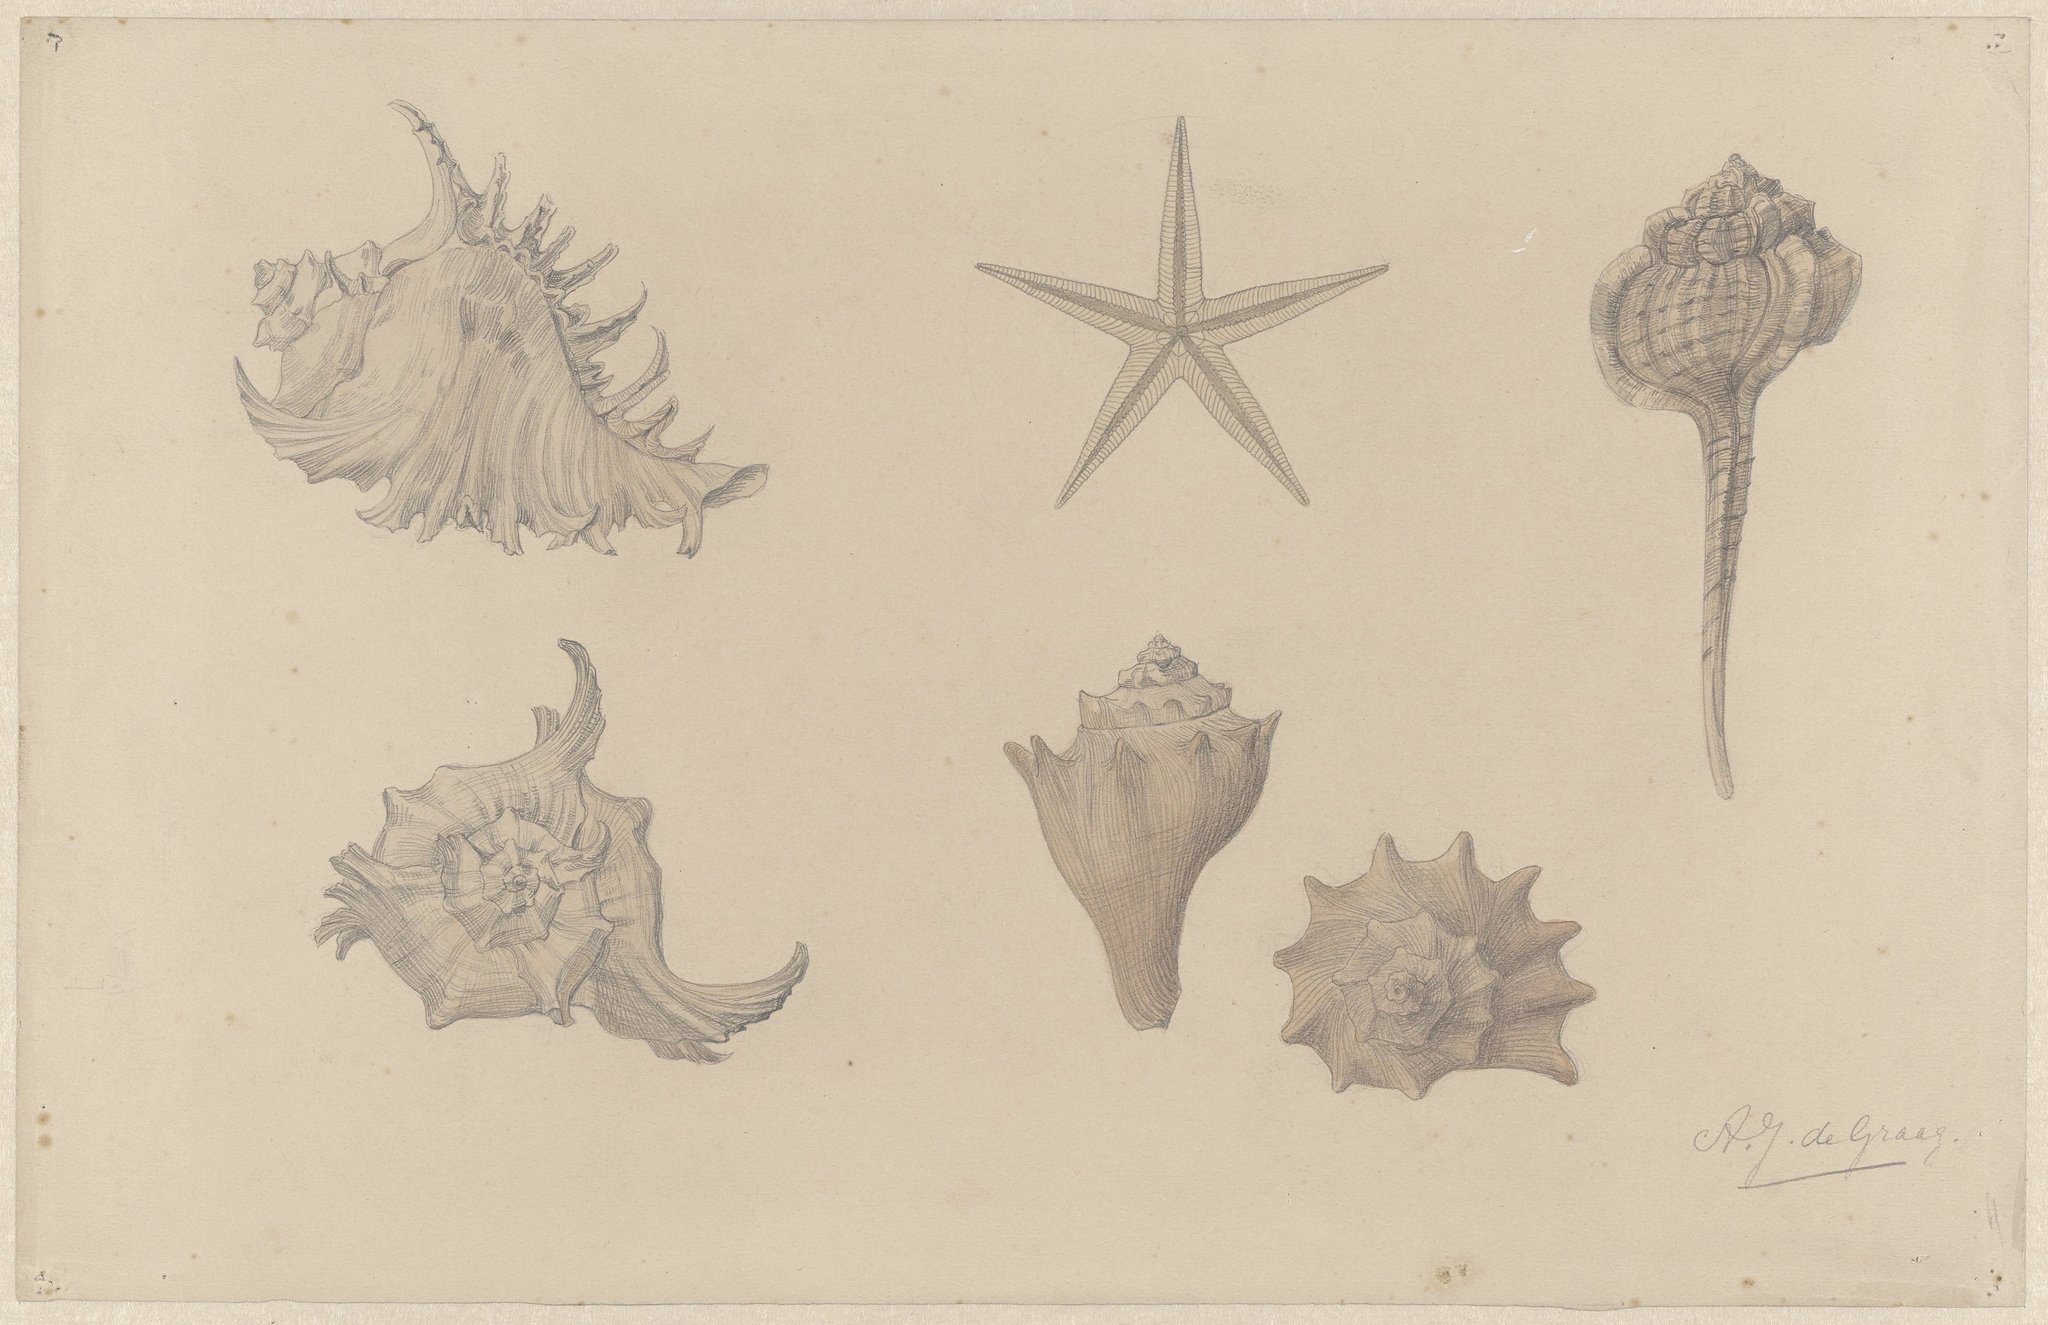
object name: drawing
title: Studieblad met schelpen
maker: julie de graag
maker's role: draughtsman, print maker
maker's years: 1877-1924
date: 1887-1924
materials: paper, pencil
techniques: brush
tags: echinoderms: starfish, lower animals (+ shell, snail-shell etc.)